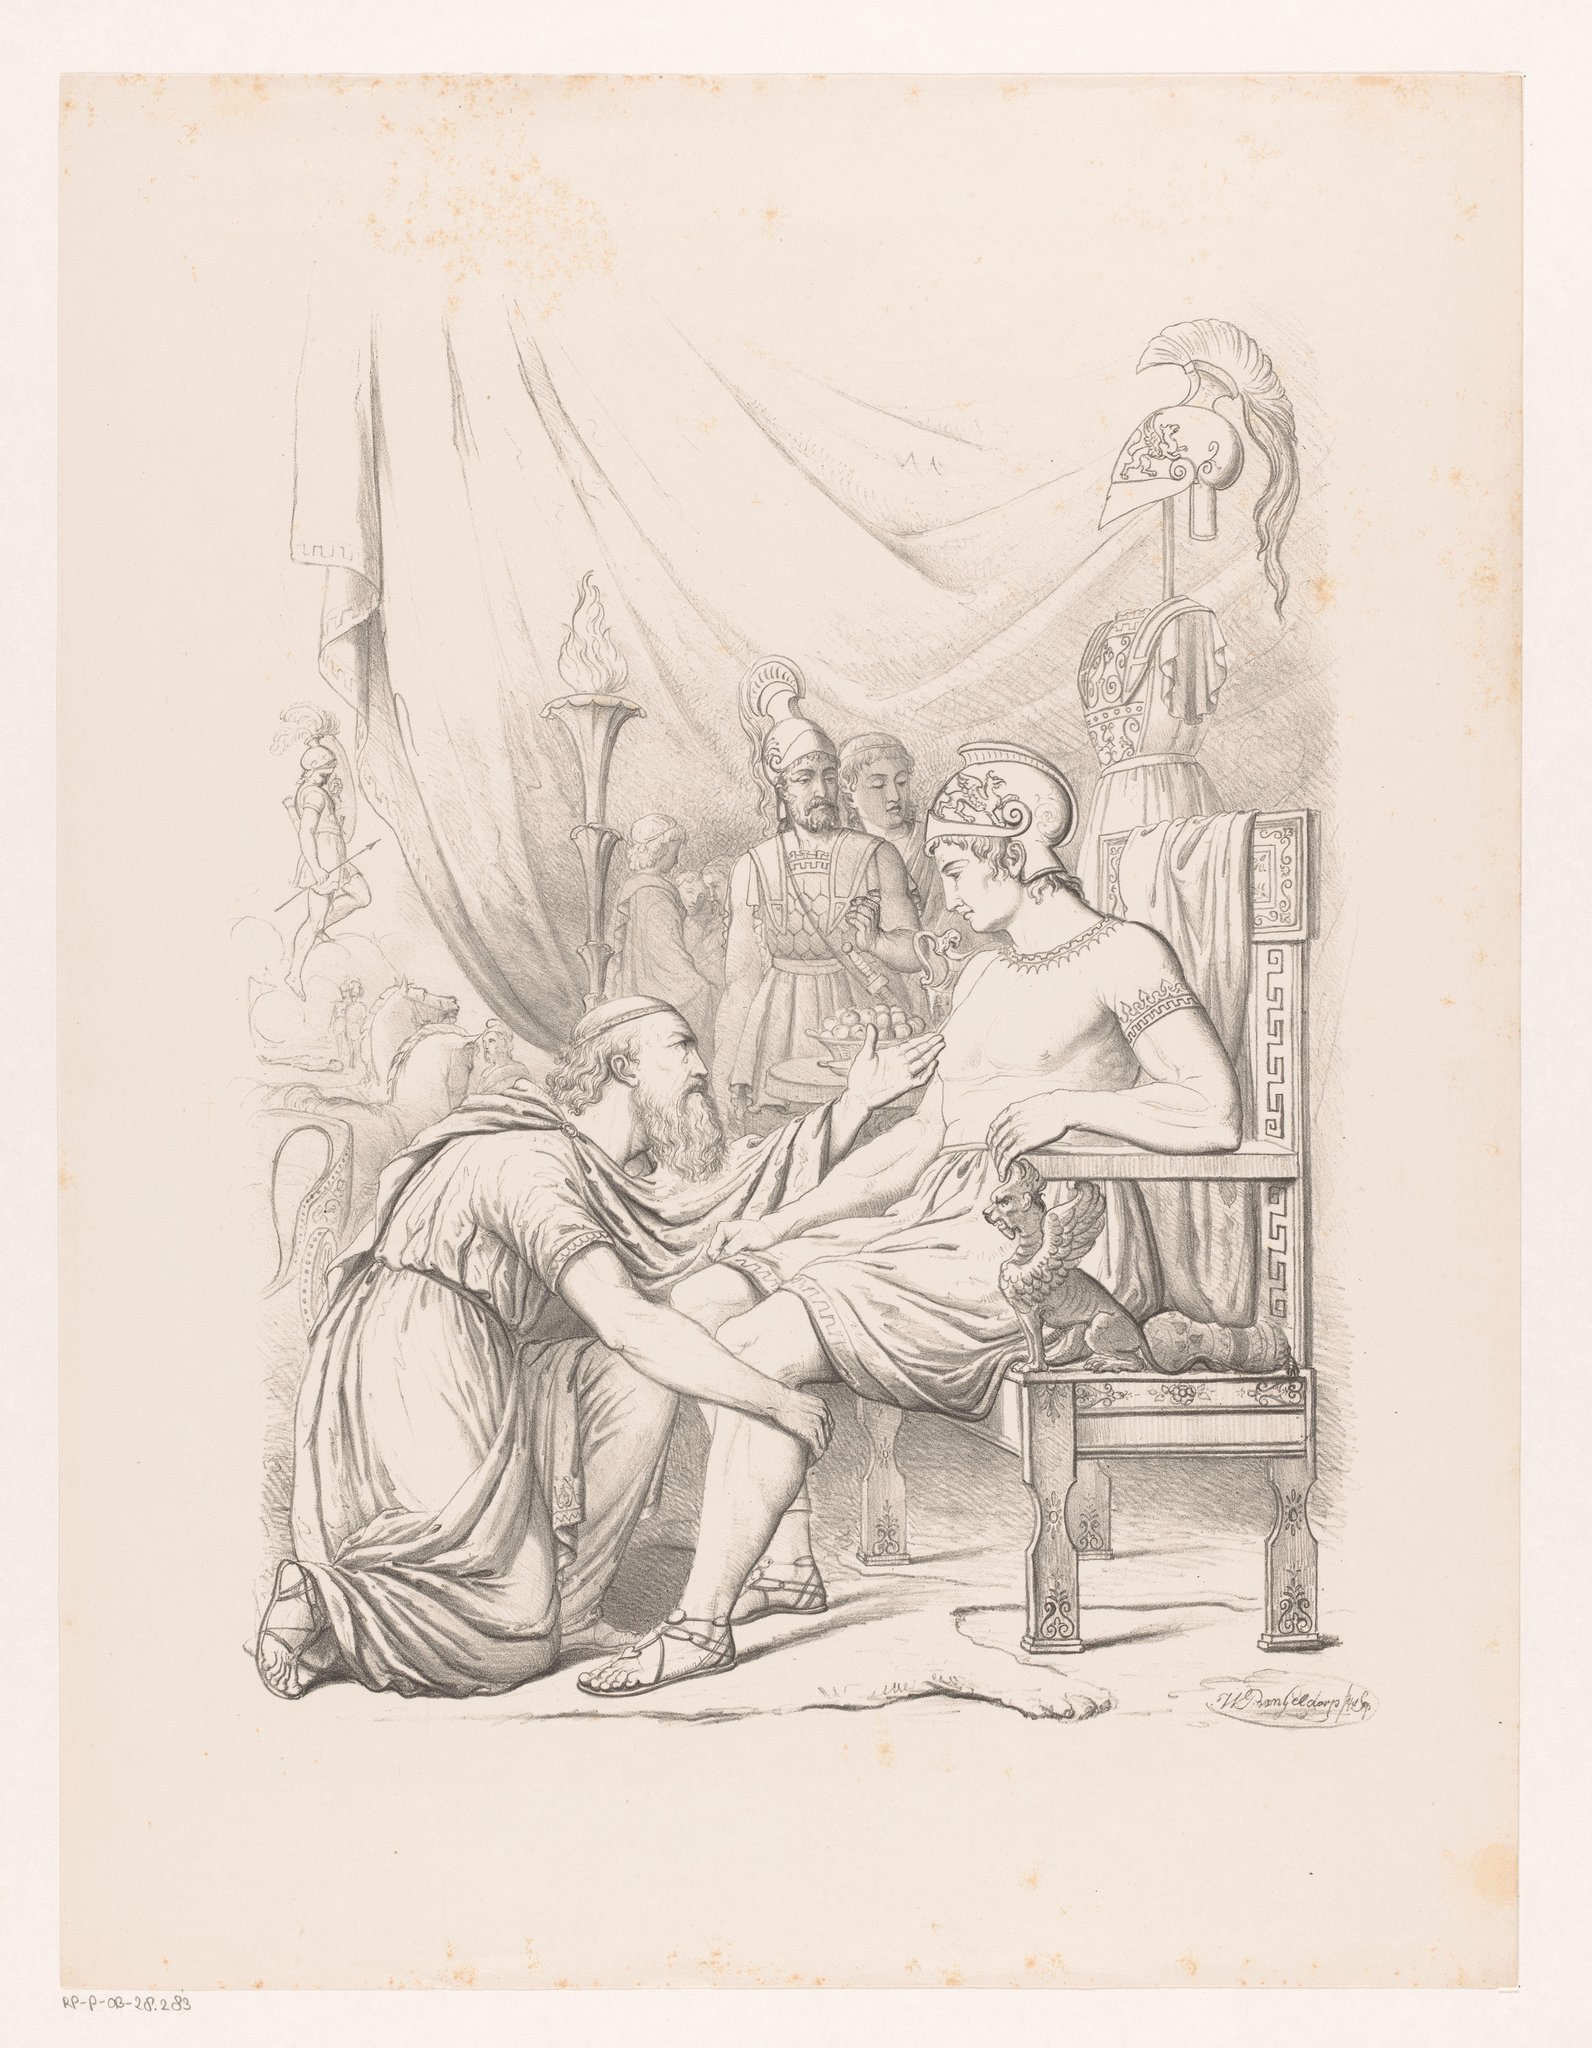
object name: print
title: Priamus vraagt aan Achilles het lichaam van Hector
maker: wilhelmus petrus van geldorp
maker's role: print maker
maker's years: 1832-1900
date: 1870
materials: paper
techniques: lithograph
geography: rotterdam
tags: priam ransoming hector's body (iliad xxiv)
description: Koning Priamus is, onder begeleiding van Mercurius, op bezoek bij Achilles. Zijn zoon Hector is tijdens de Trojaanse oorlog door Achilles om het leven gebracht. Priamus smeekt hem het toegetakelde lichaam terug te geven. Achilles is tot tranen geroerd en stemt in.